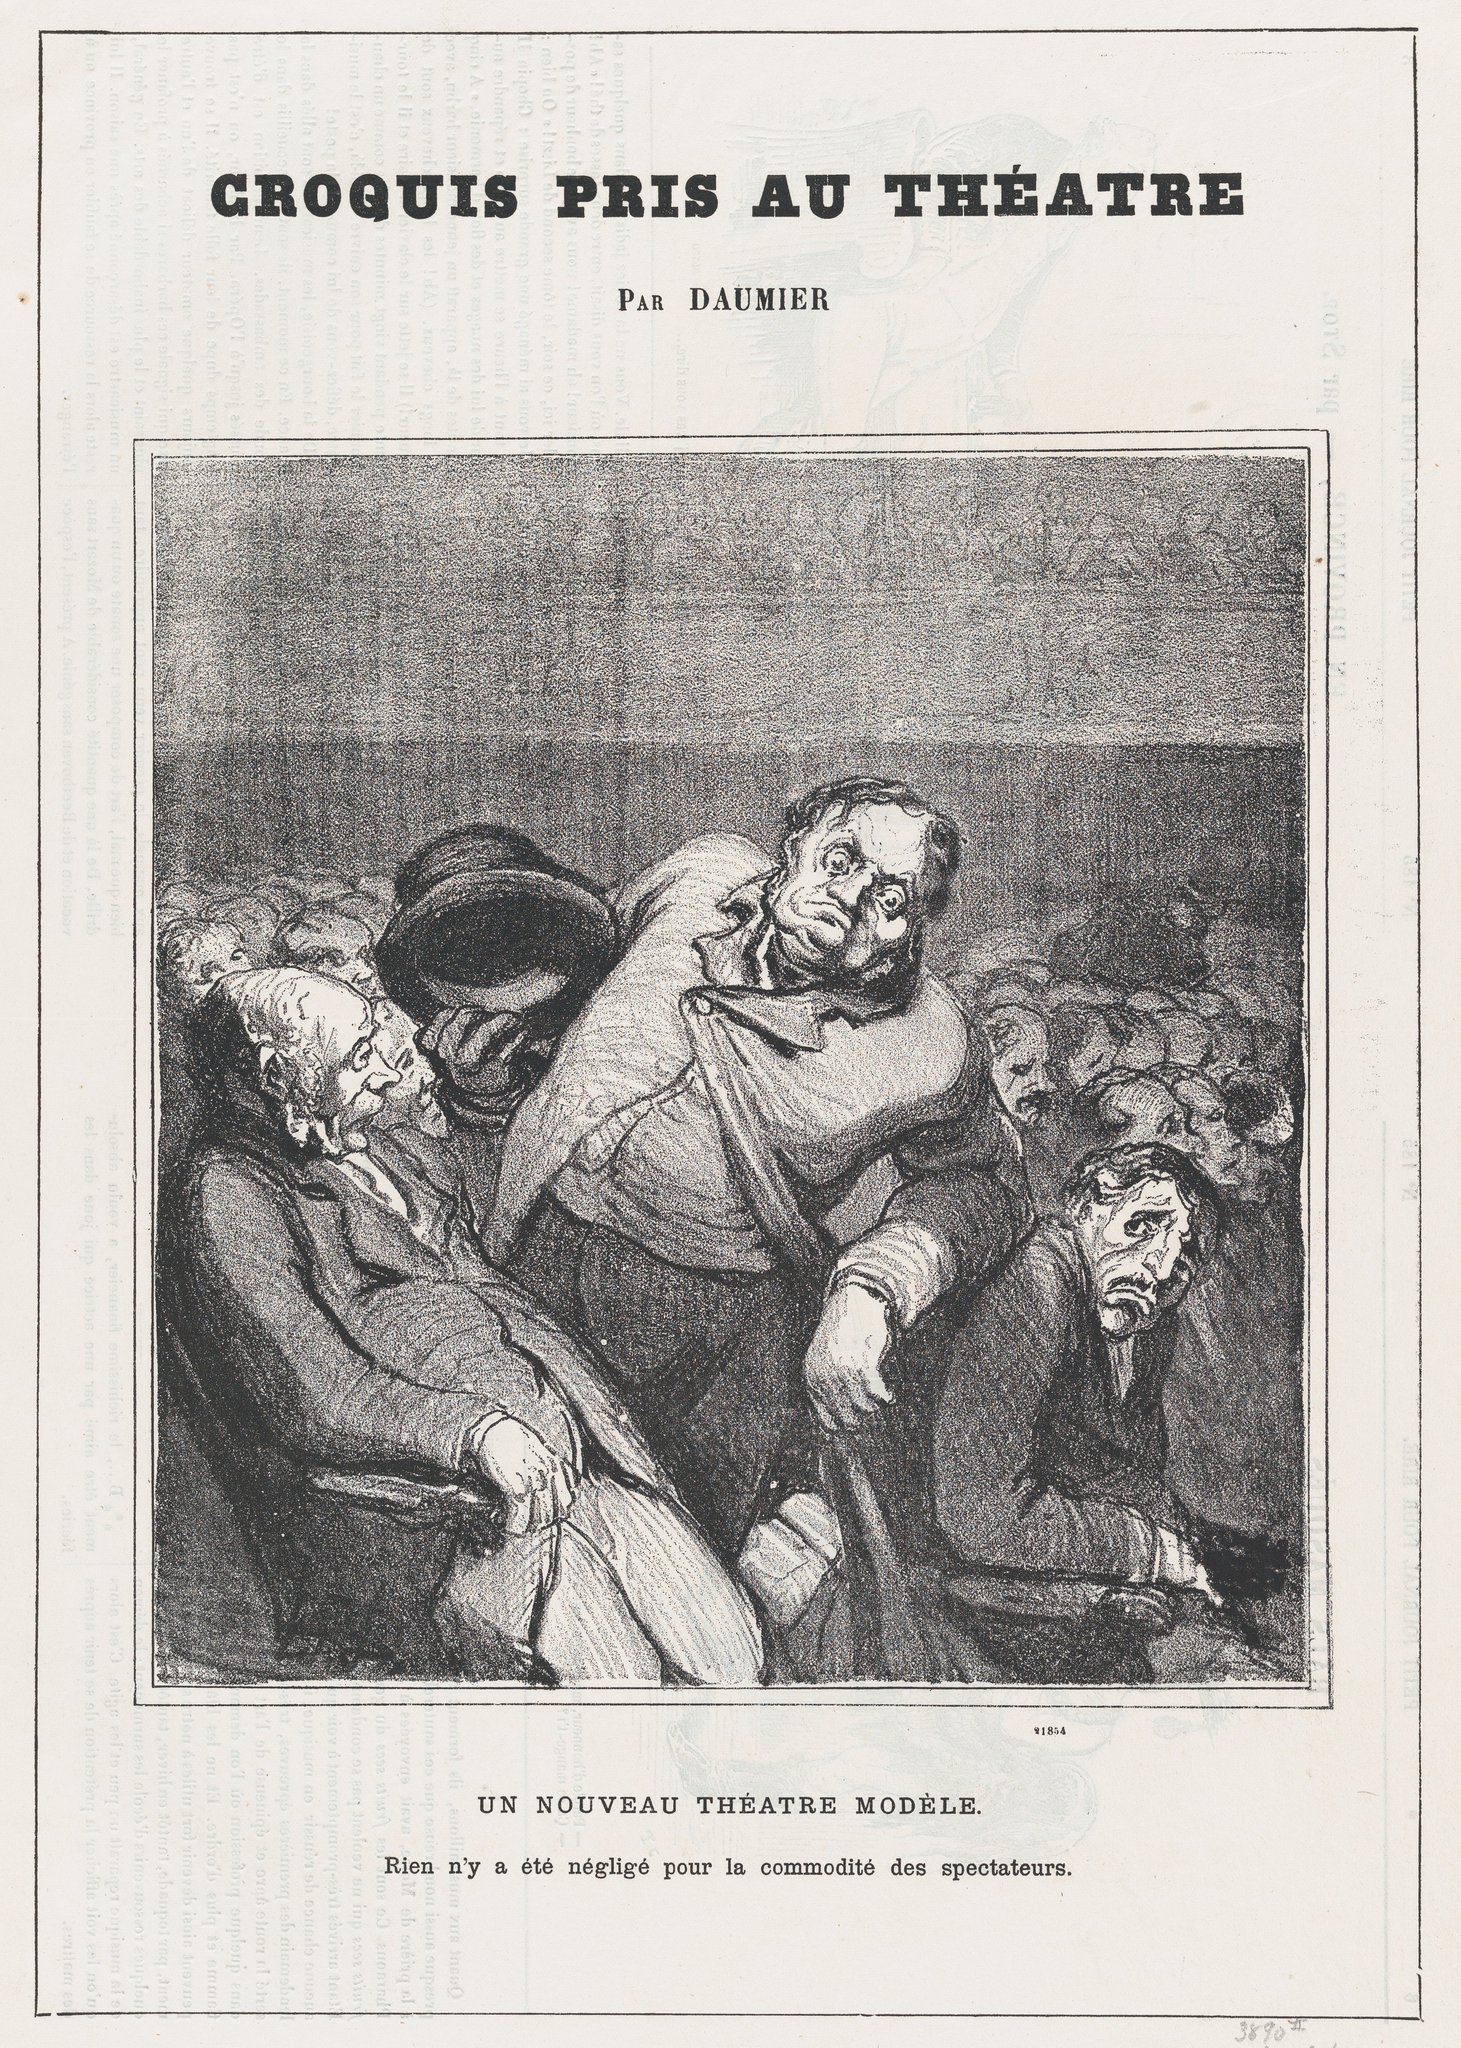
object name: print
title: A new theater model, from 'Theater sketches,' published in Le Petit Journal pour Rire, January 30, 1864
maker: honoré daumier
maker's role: artist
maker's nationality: french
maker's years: 1808-1879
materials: paper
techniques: lithograph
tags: satire,men